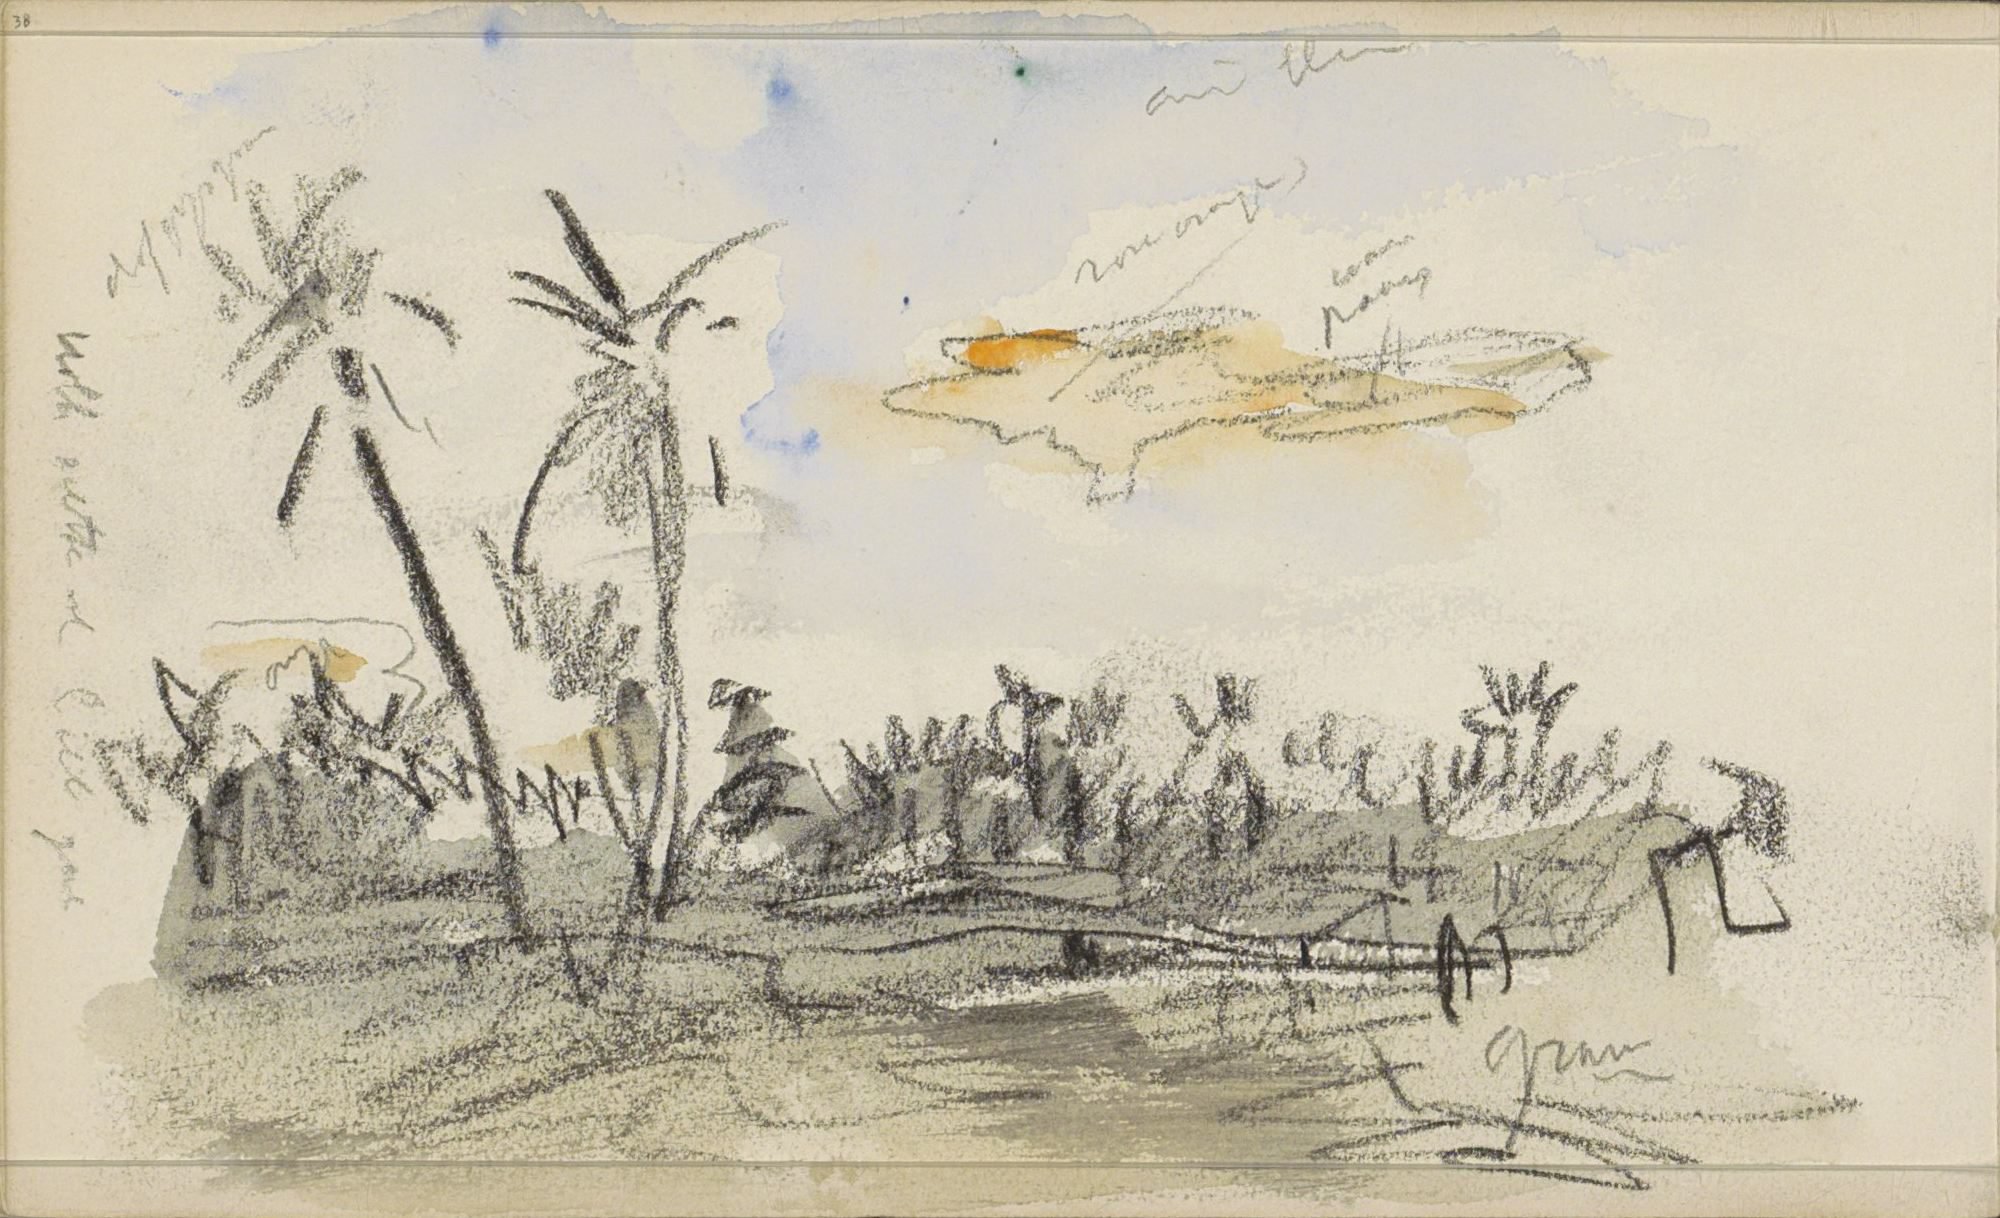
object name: sketchbook leaf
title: Oase in Biskra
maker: marius bauer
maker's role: draughtsman, print maker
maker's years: 1867-1932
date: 1922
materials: chalk, paper, watercolor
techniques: brush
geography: biskra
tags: plants (in general), oasis, trees: palm-tree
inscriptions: kleurnotitie, handgeschreven in potlood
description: Pagina 38 uit een schetsboek met 31 bladen.